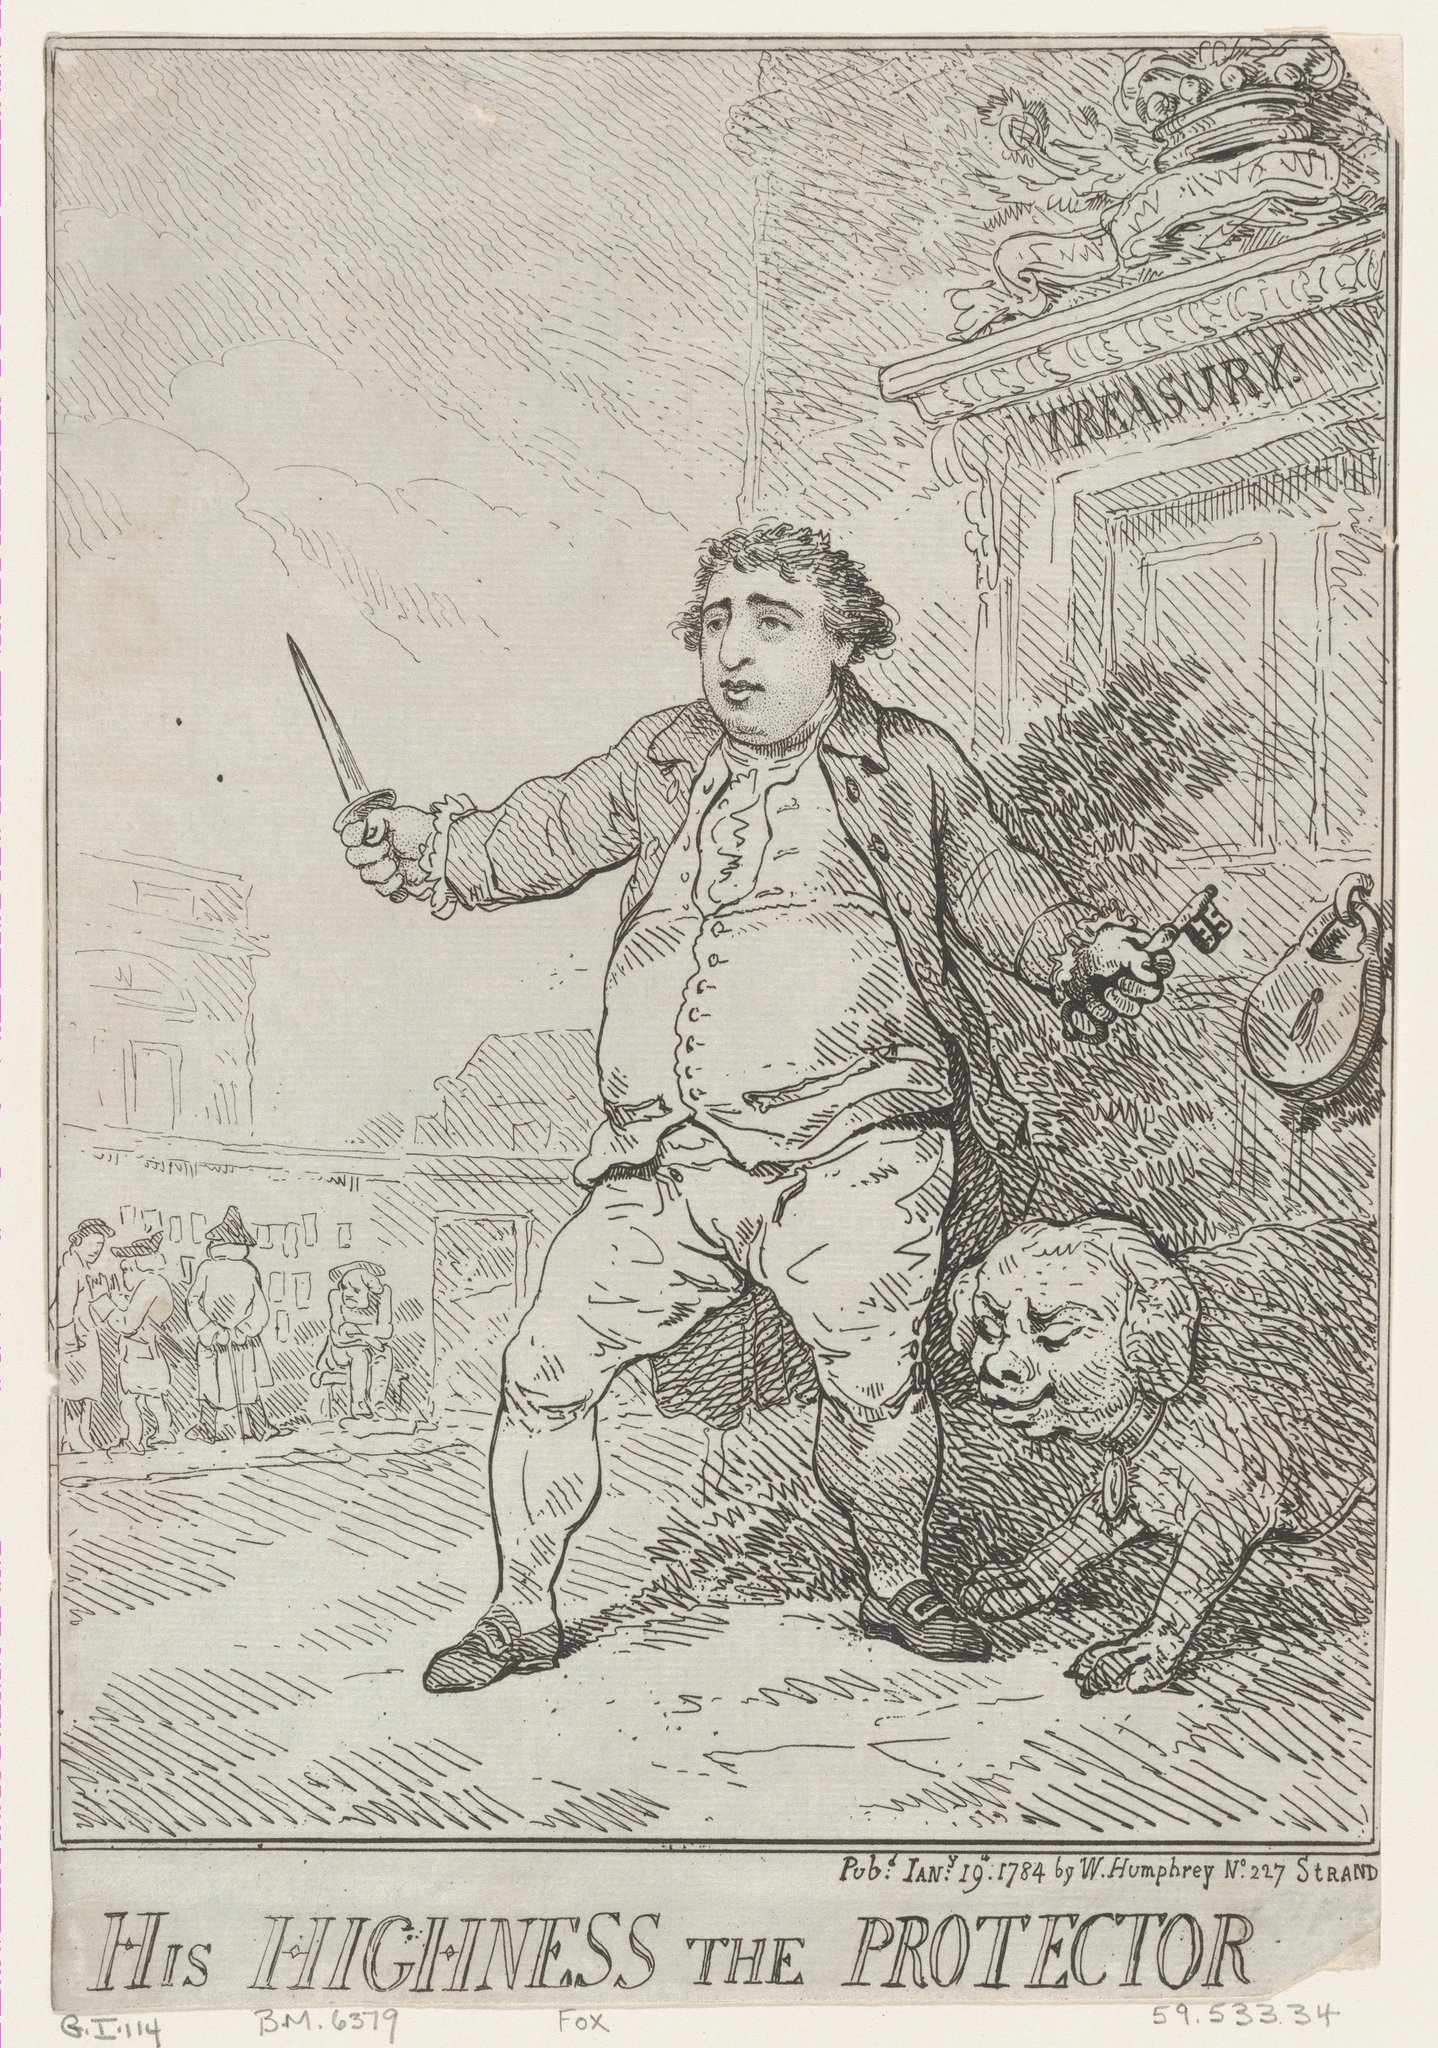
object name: print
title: His Highness The Protector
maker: thomas rowlandson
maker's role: artist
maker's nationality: british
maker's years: 1757-1827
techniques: etching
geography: london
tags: satire,men,politics